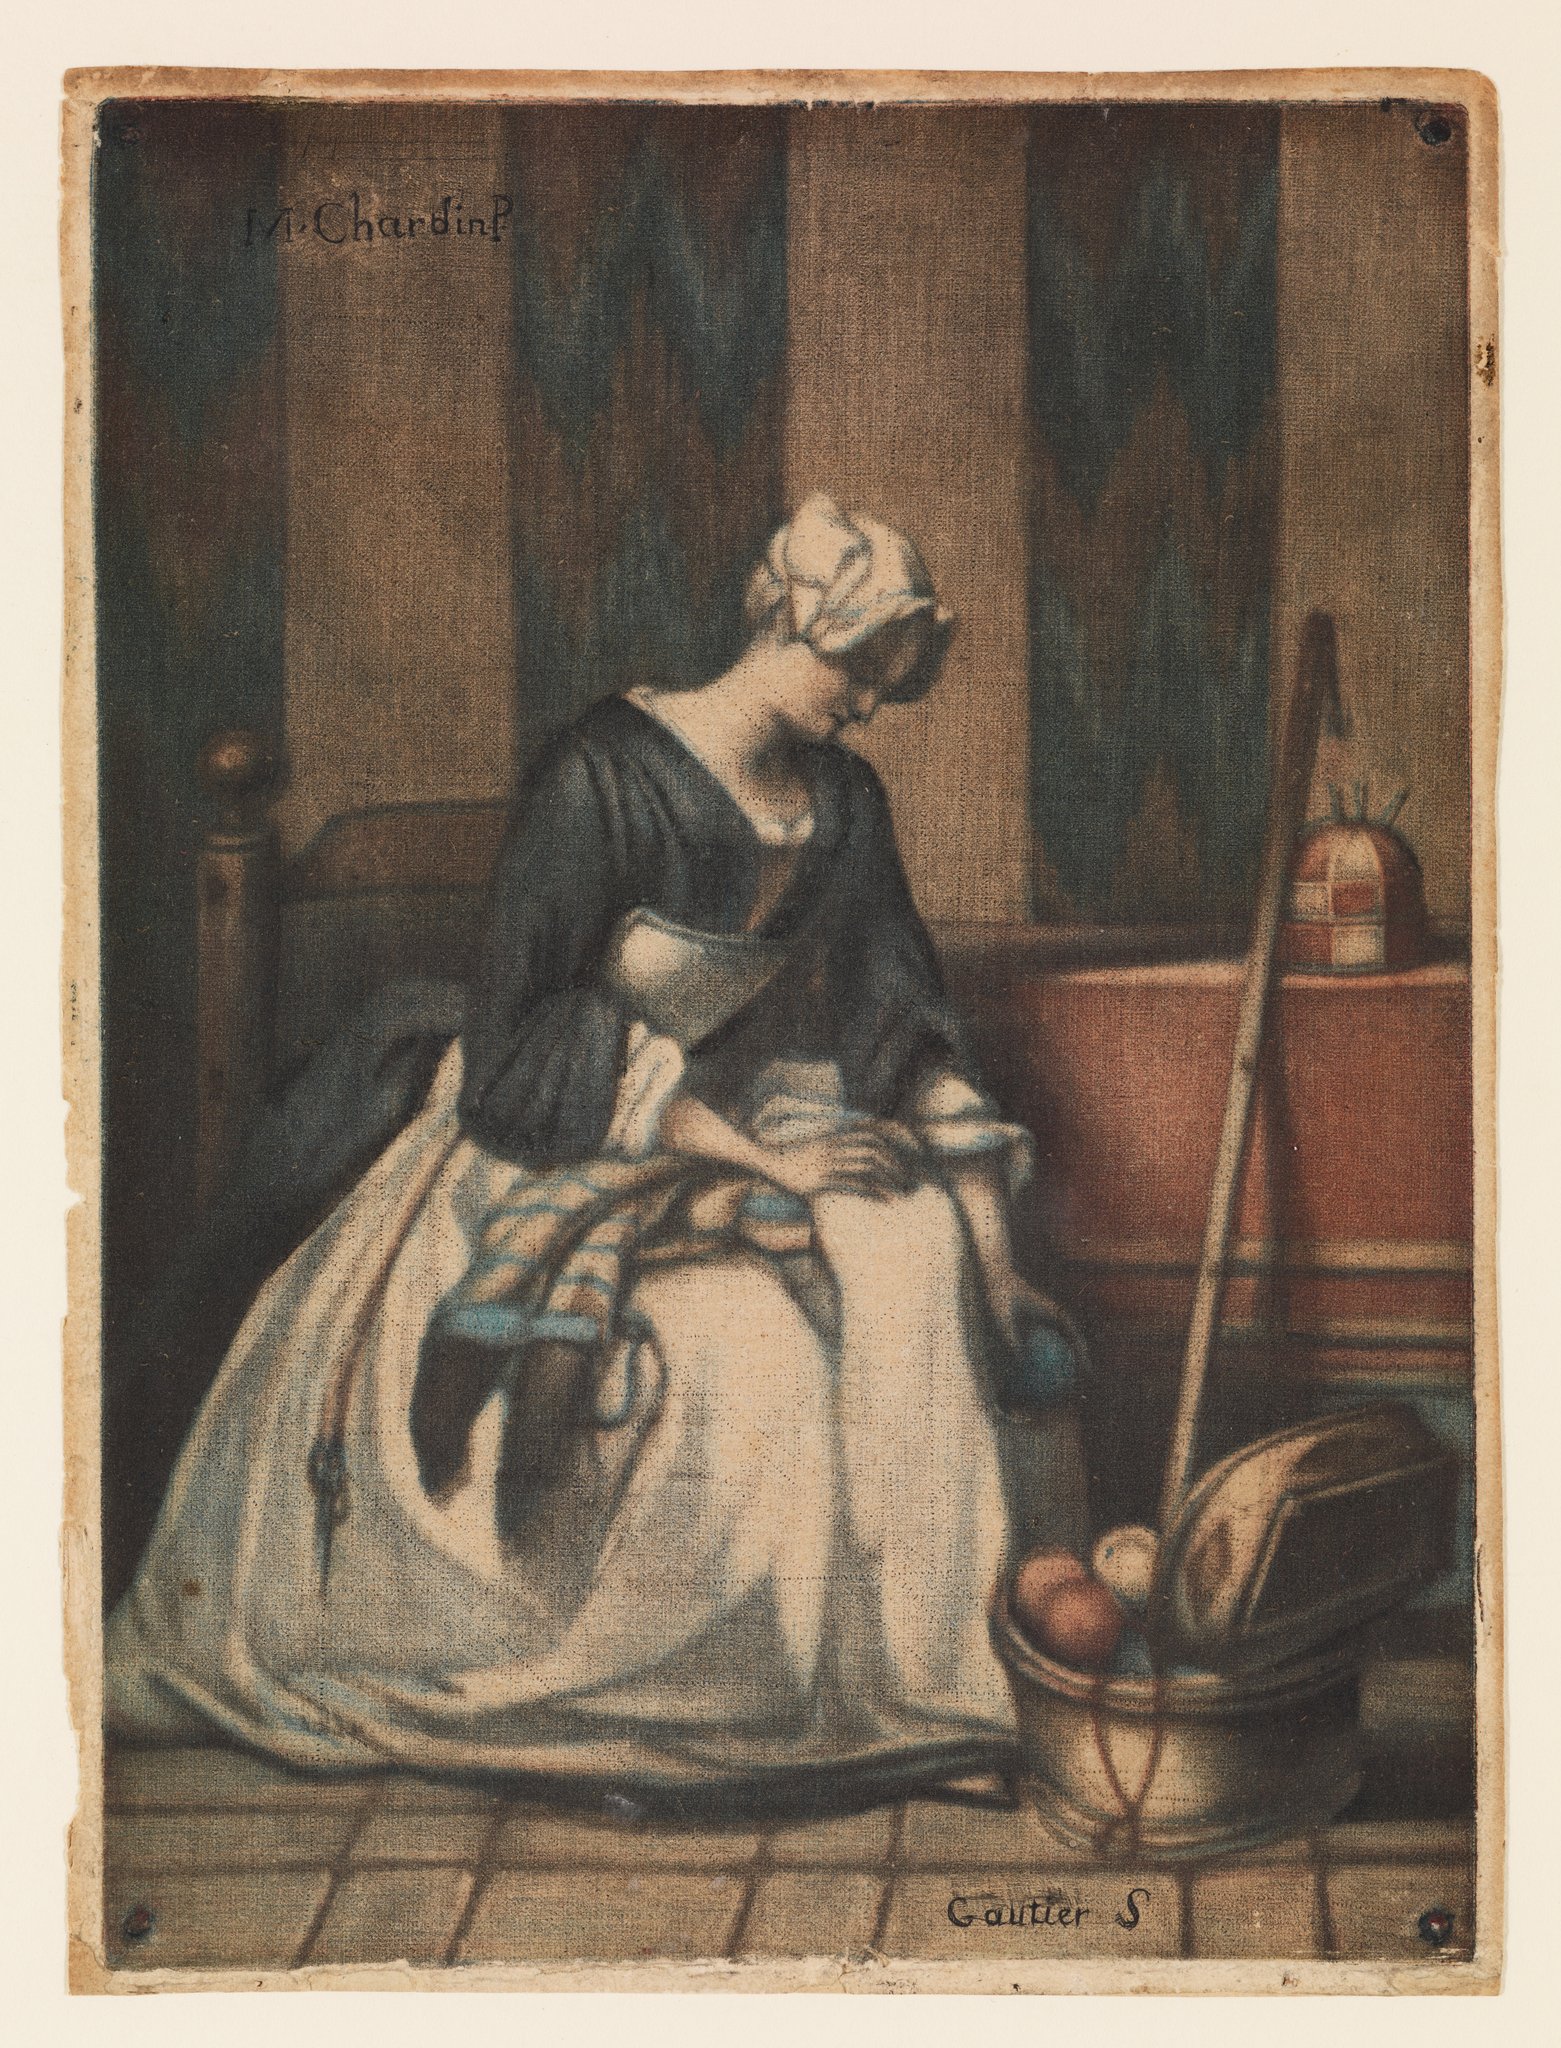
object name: print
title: The Embroiderer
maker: jacques fabien gautier dagoty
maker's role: artist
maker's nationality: french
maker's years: 1716-1785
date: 1701-1800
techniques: mezzotint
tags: women